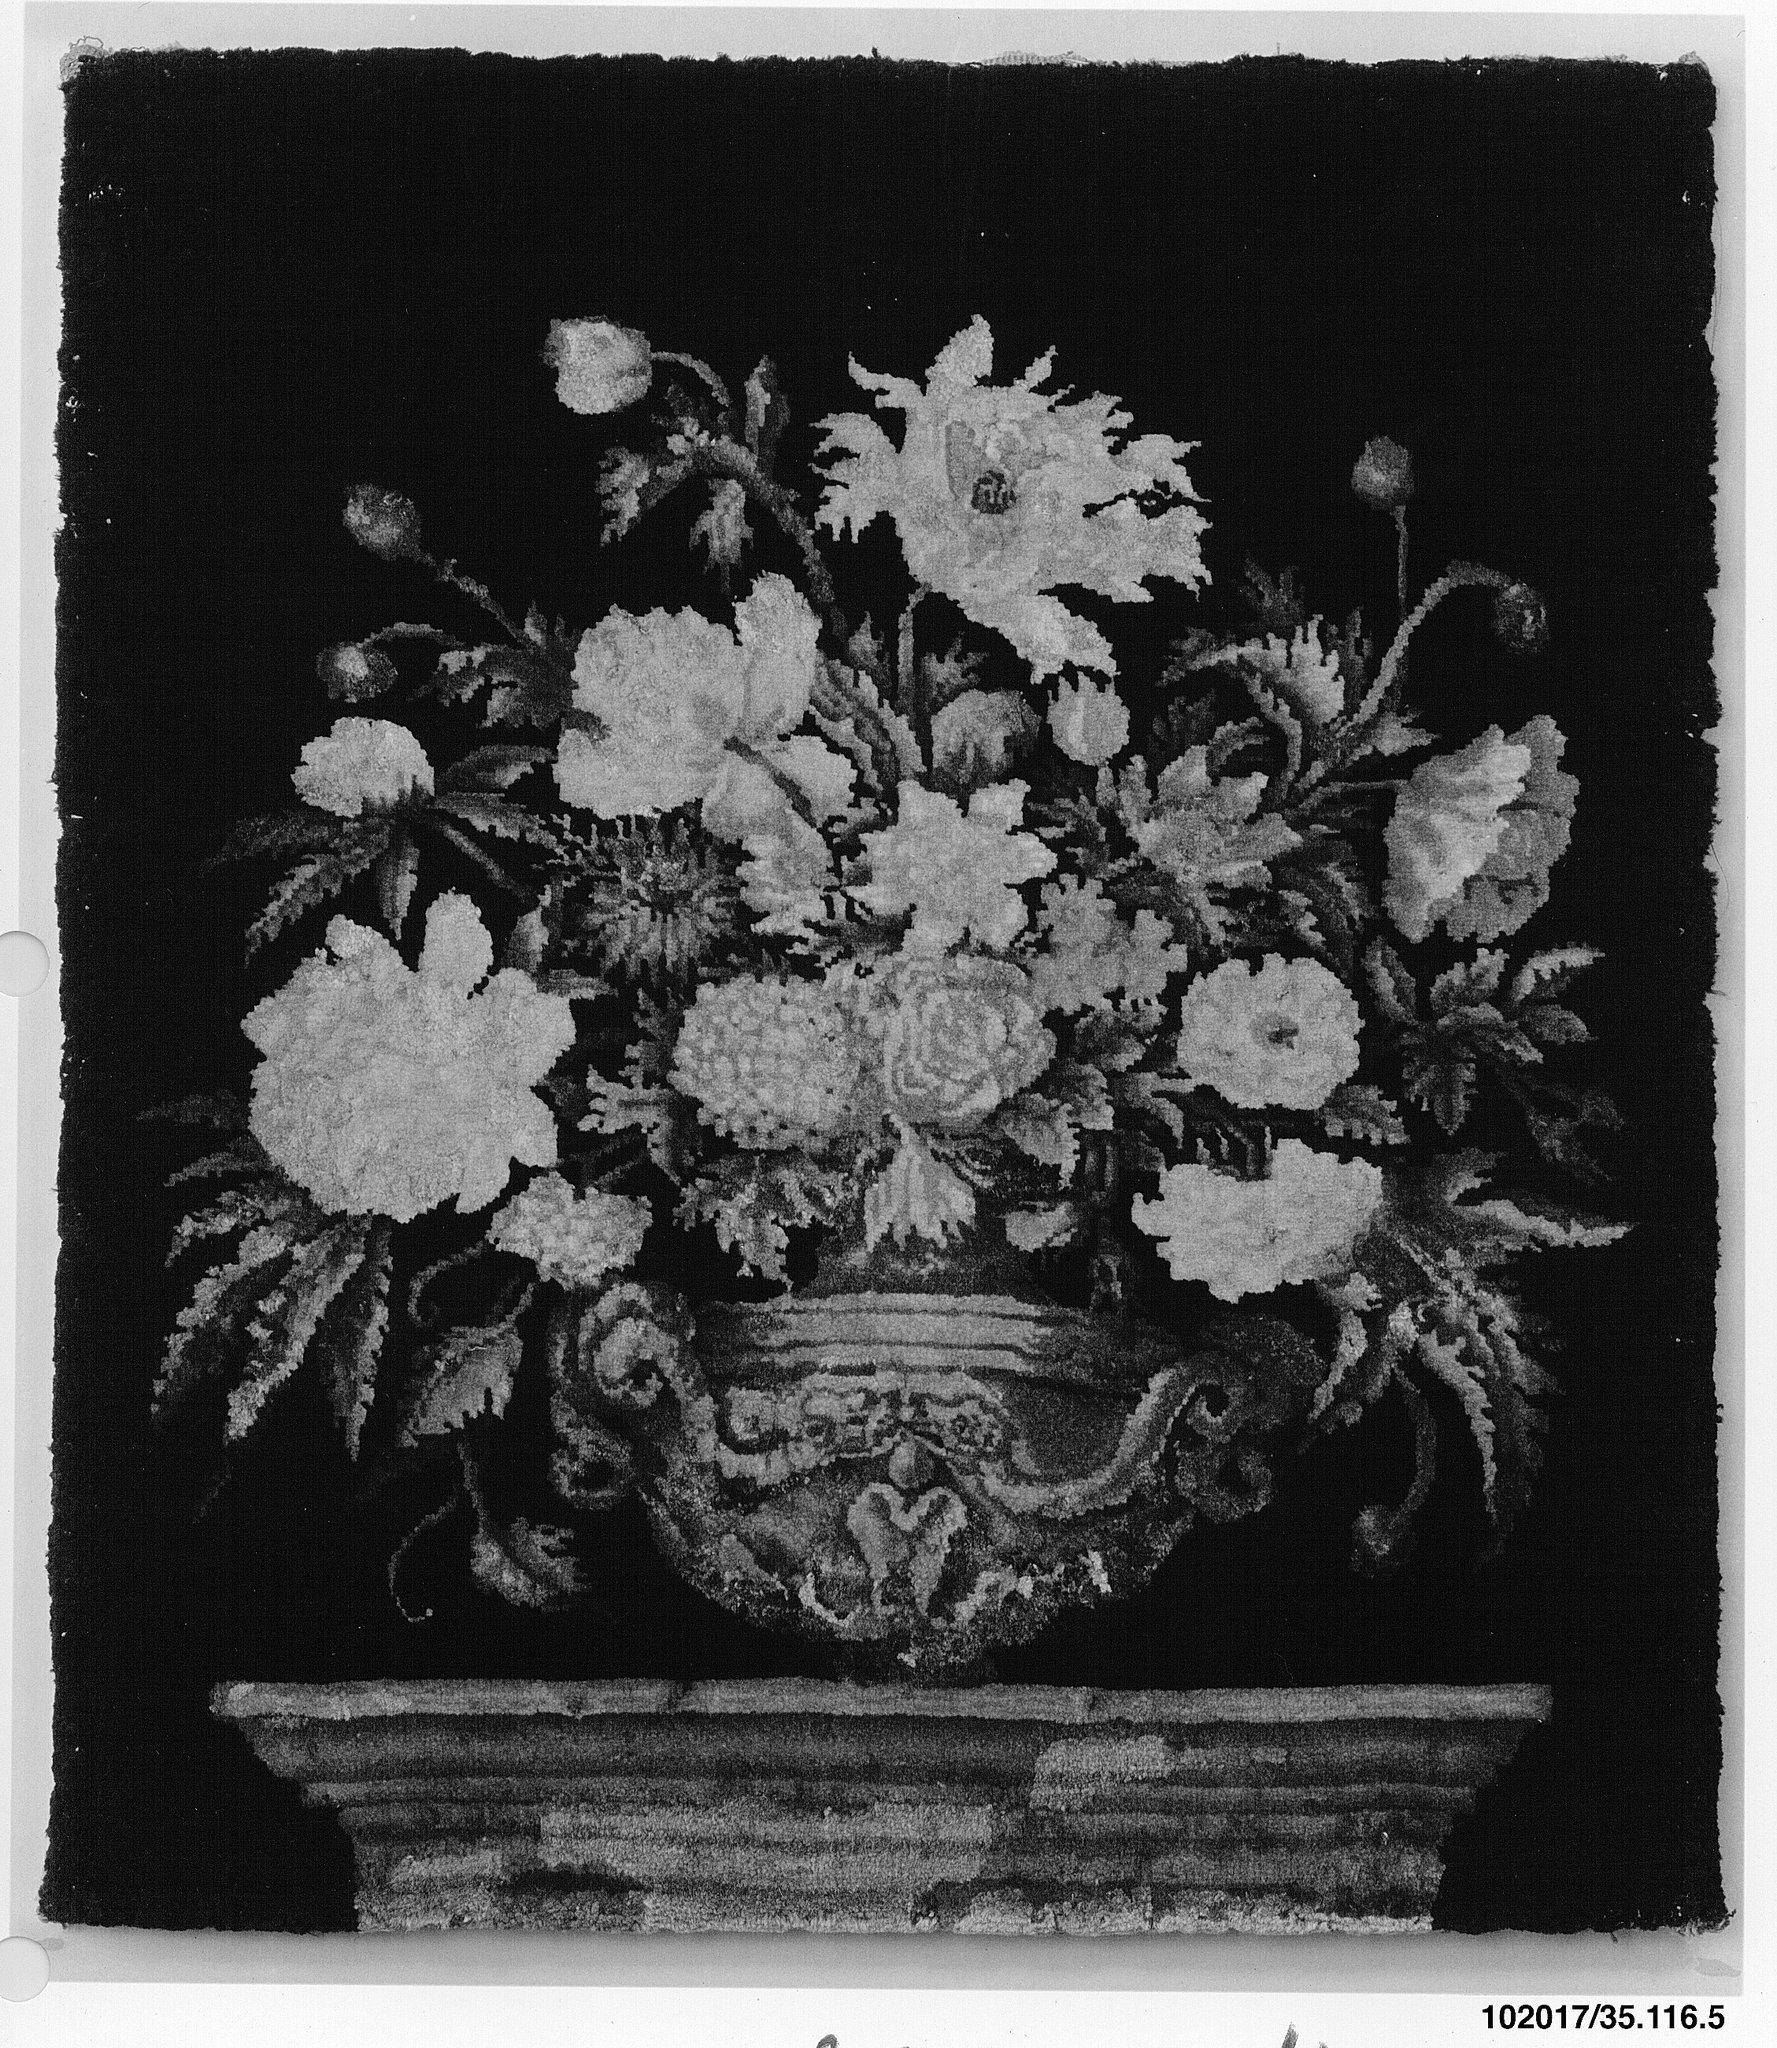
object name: panel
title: Flowers in a silver vase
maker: savonnerie manufactory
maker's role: manufactory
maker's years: 1626-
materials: wool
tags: flowers